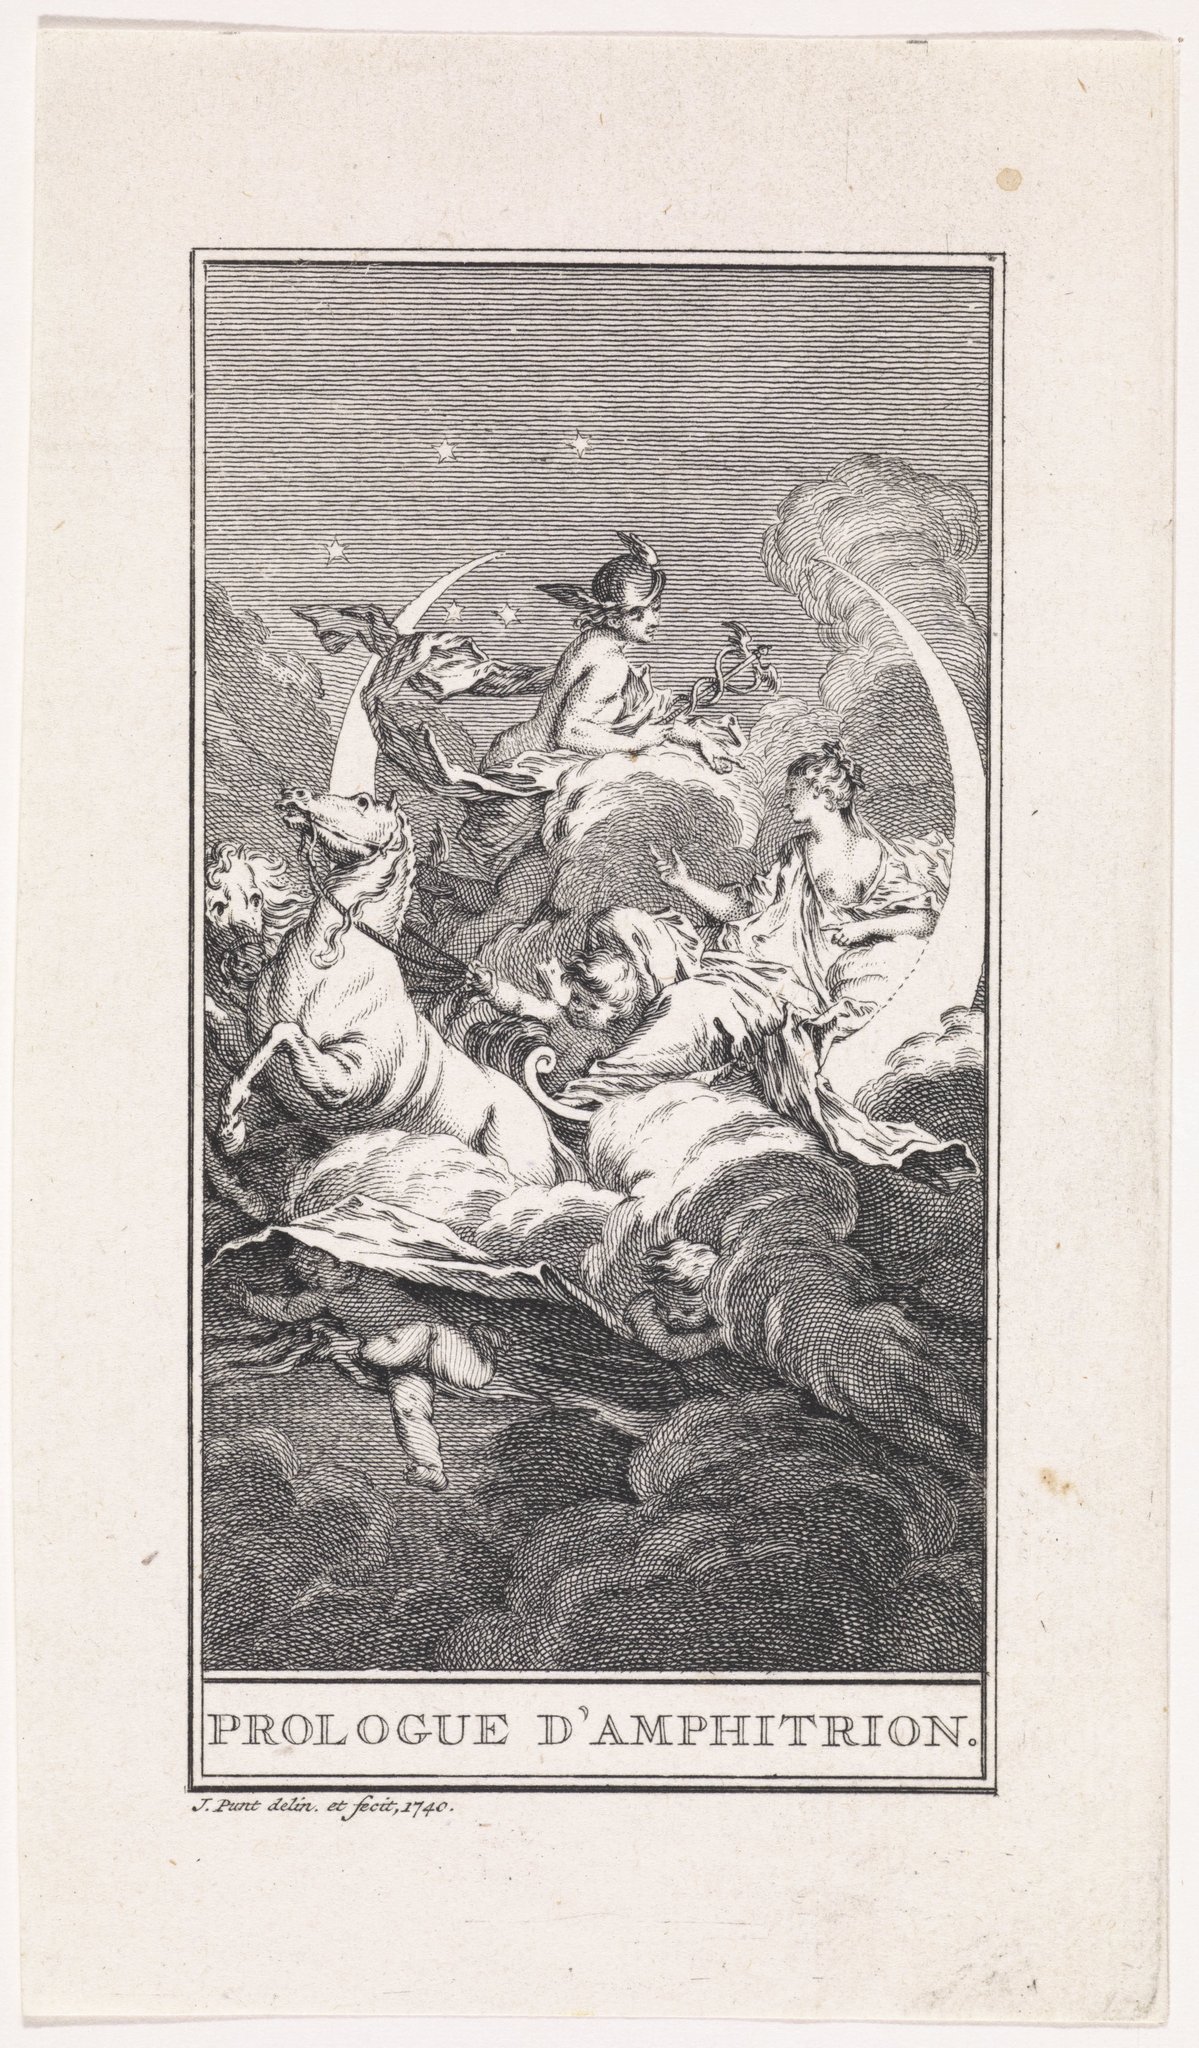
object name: print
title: Prologue d'Amphitrion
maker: jan punt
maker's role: draughtsman, print maker, publisher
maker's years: 1711-1779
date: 1740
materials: paper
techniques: engraving, etching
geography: amsterdam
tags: (moliere) specific works of literature (with author, title), (story of) mercury (hermes), personification of the night, 'nox'; 'notte', 'carro della notte', 'serenità della notte' (ripa)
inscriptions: collector's mark: Lugt 2228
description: De gepersonifieerde Nacht, vergezeld door putti, rijdt in haar wagen voortgetrokken door paarden langs de maan. Ze is in gesprek met Mercurius. Scène uit het toneelstuk Amphitryon, van Molière.